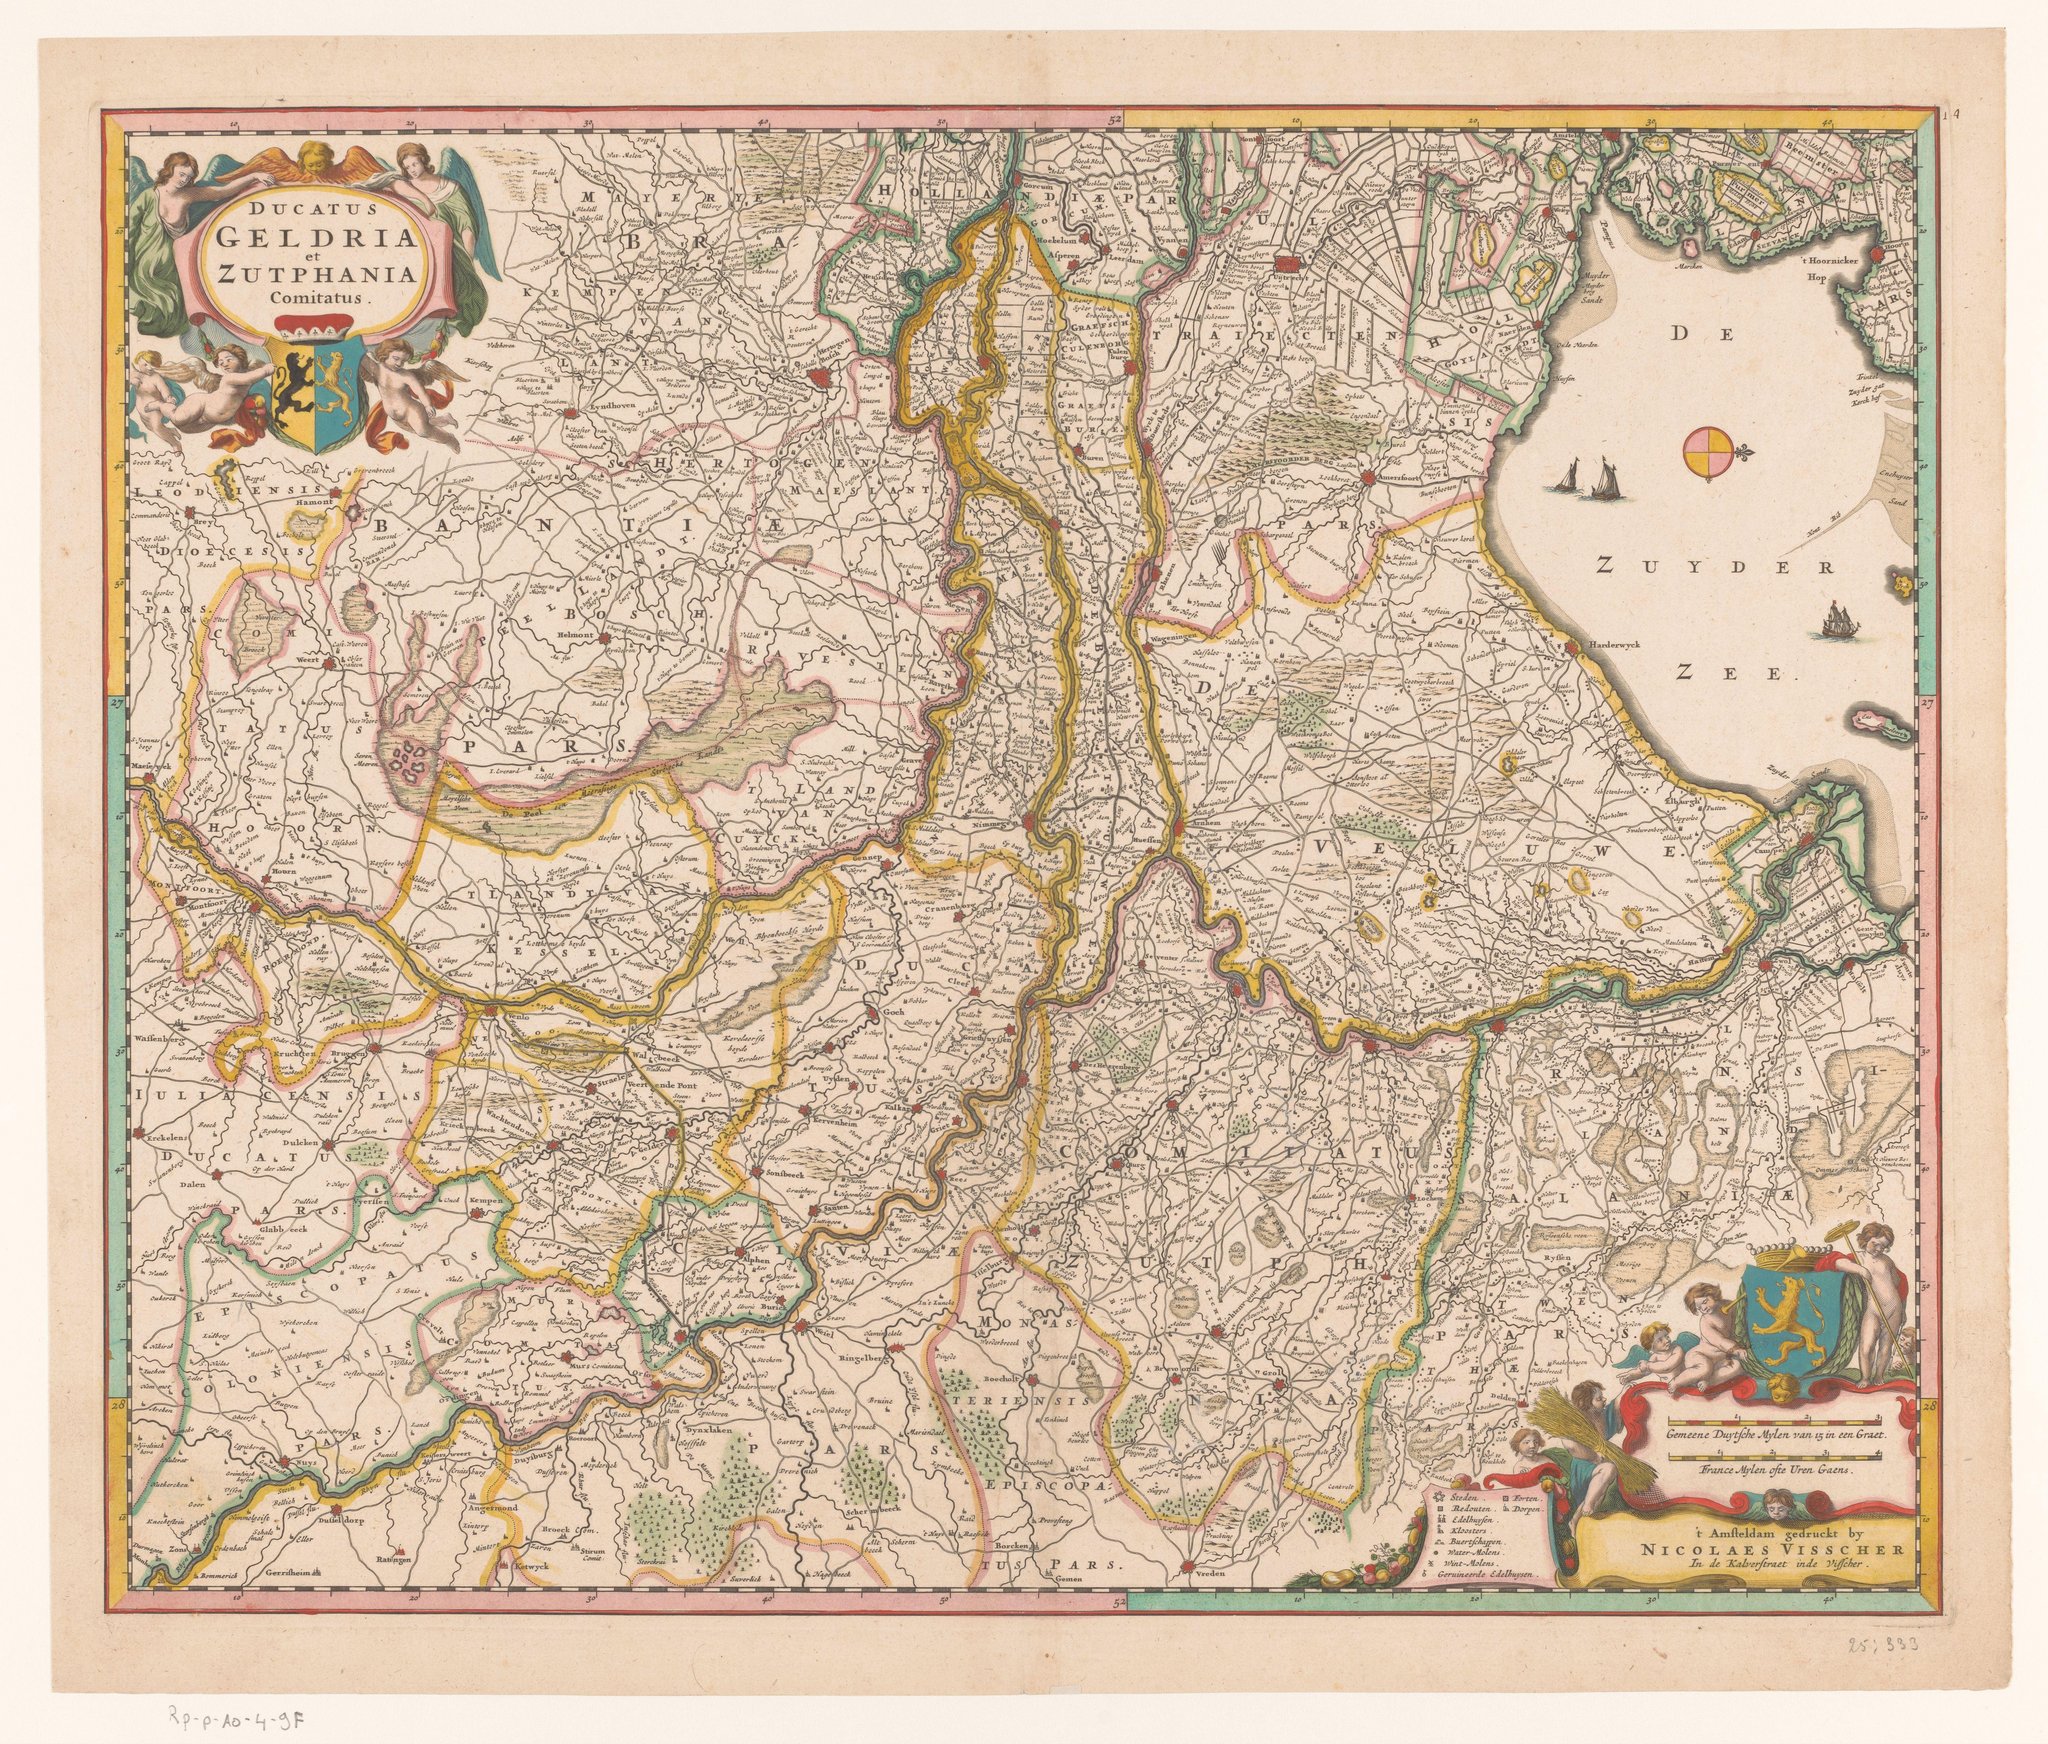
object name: print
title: Ducatus Geldria et Zutphania comitatus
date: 1656-1677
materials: paper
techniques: engraving, etching, hand coloring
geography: amsterdam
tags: maps of separate countries or regions, coat of arms (as symbol of the state, etc.) (+ province; provincial), gelderland, guelders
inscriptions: collector's mark: Lugt 2228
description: Linksboven de titelcartouche, met onderin het wapen van Gelre. Rechtsonder een cartouche met twee schaalstokken: 3 Gemeene Duytsche Mylen van 15 in een Graet / 4 France Mylen ofte Uren Gaens. Hierboven het wapen van het graafschap Zutphen, links de legenda. De kaart is voorzien van een gradenverdeling langs de randen.